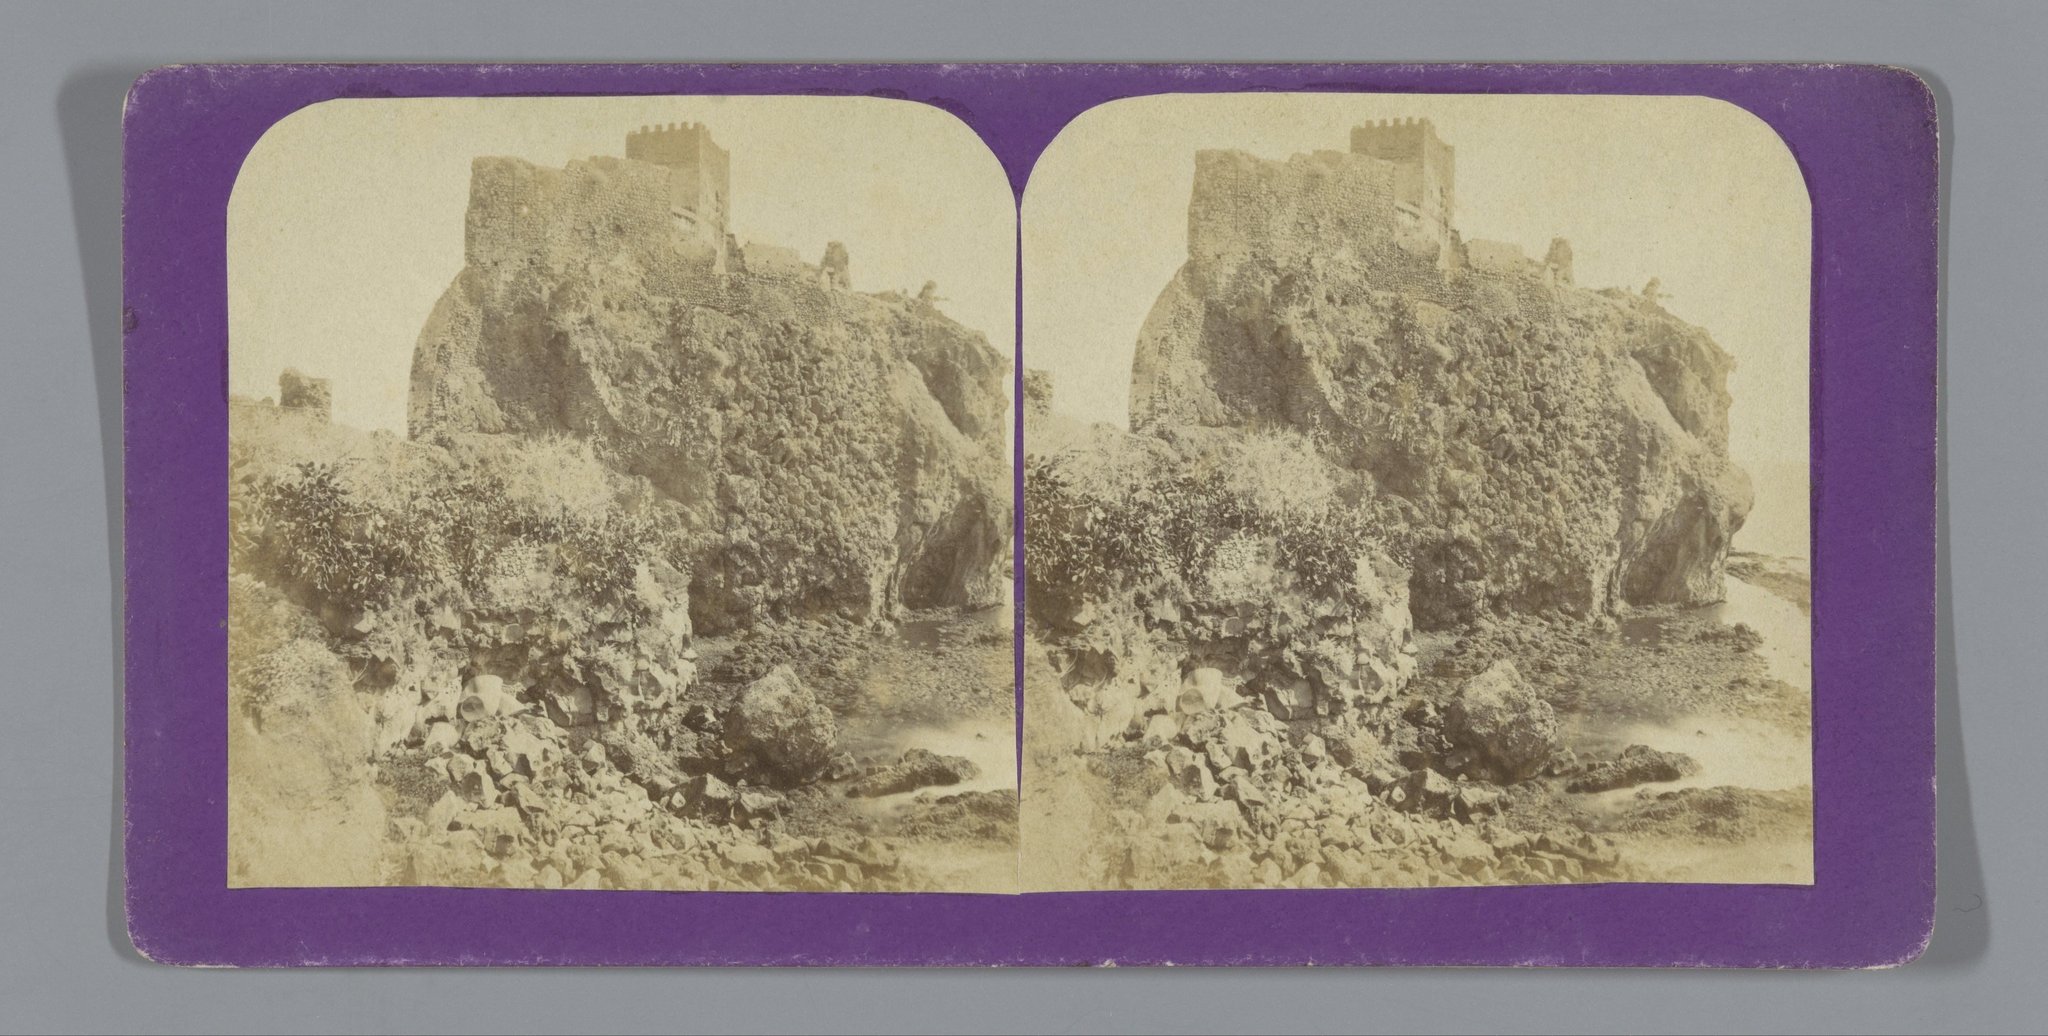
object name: stereograph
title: Aci-Castello, Catane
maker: jean andrieu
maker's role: fotograaf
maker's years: 1816-1872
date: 1862-1876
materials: cardboard, paper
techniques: albumen print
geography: catania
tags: fortress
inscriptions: title: ‘1410 Aci-Castello Catane’